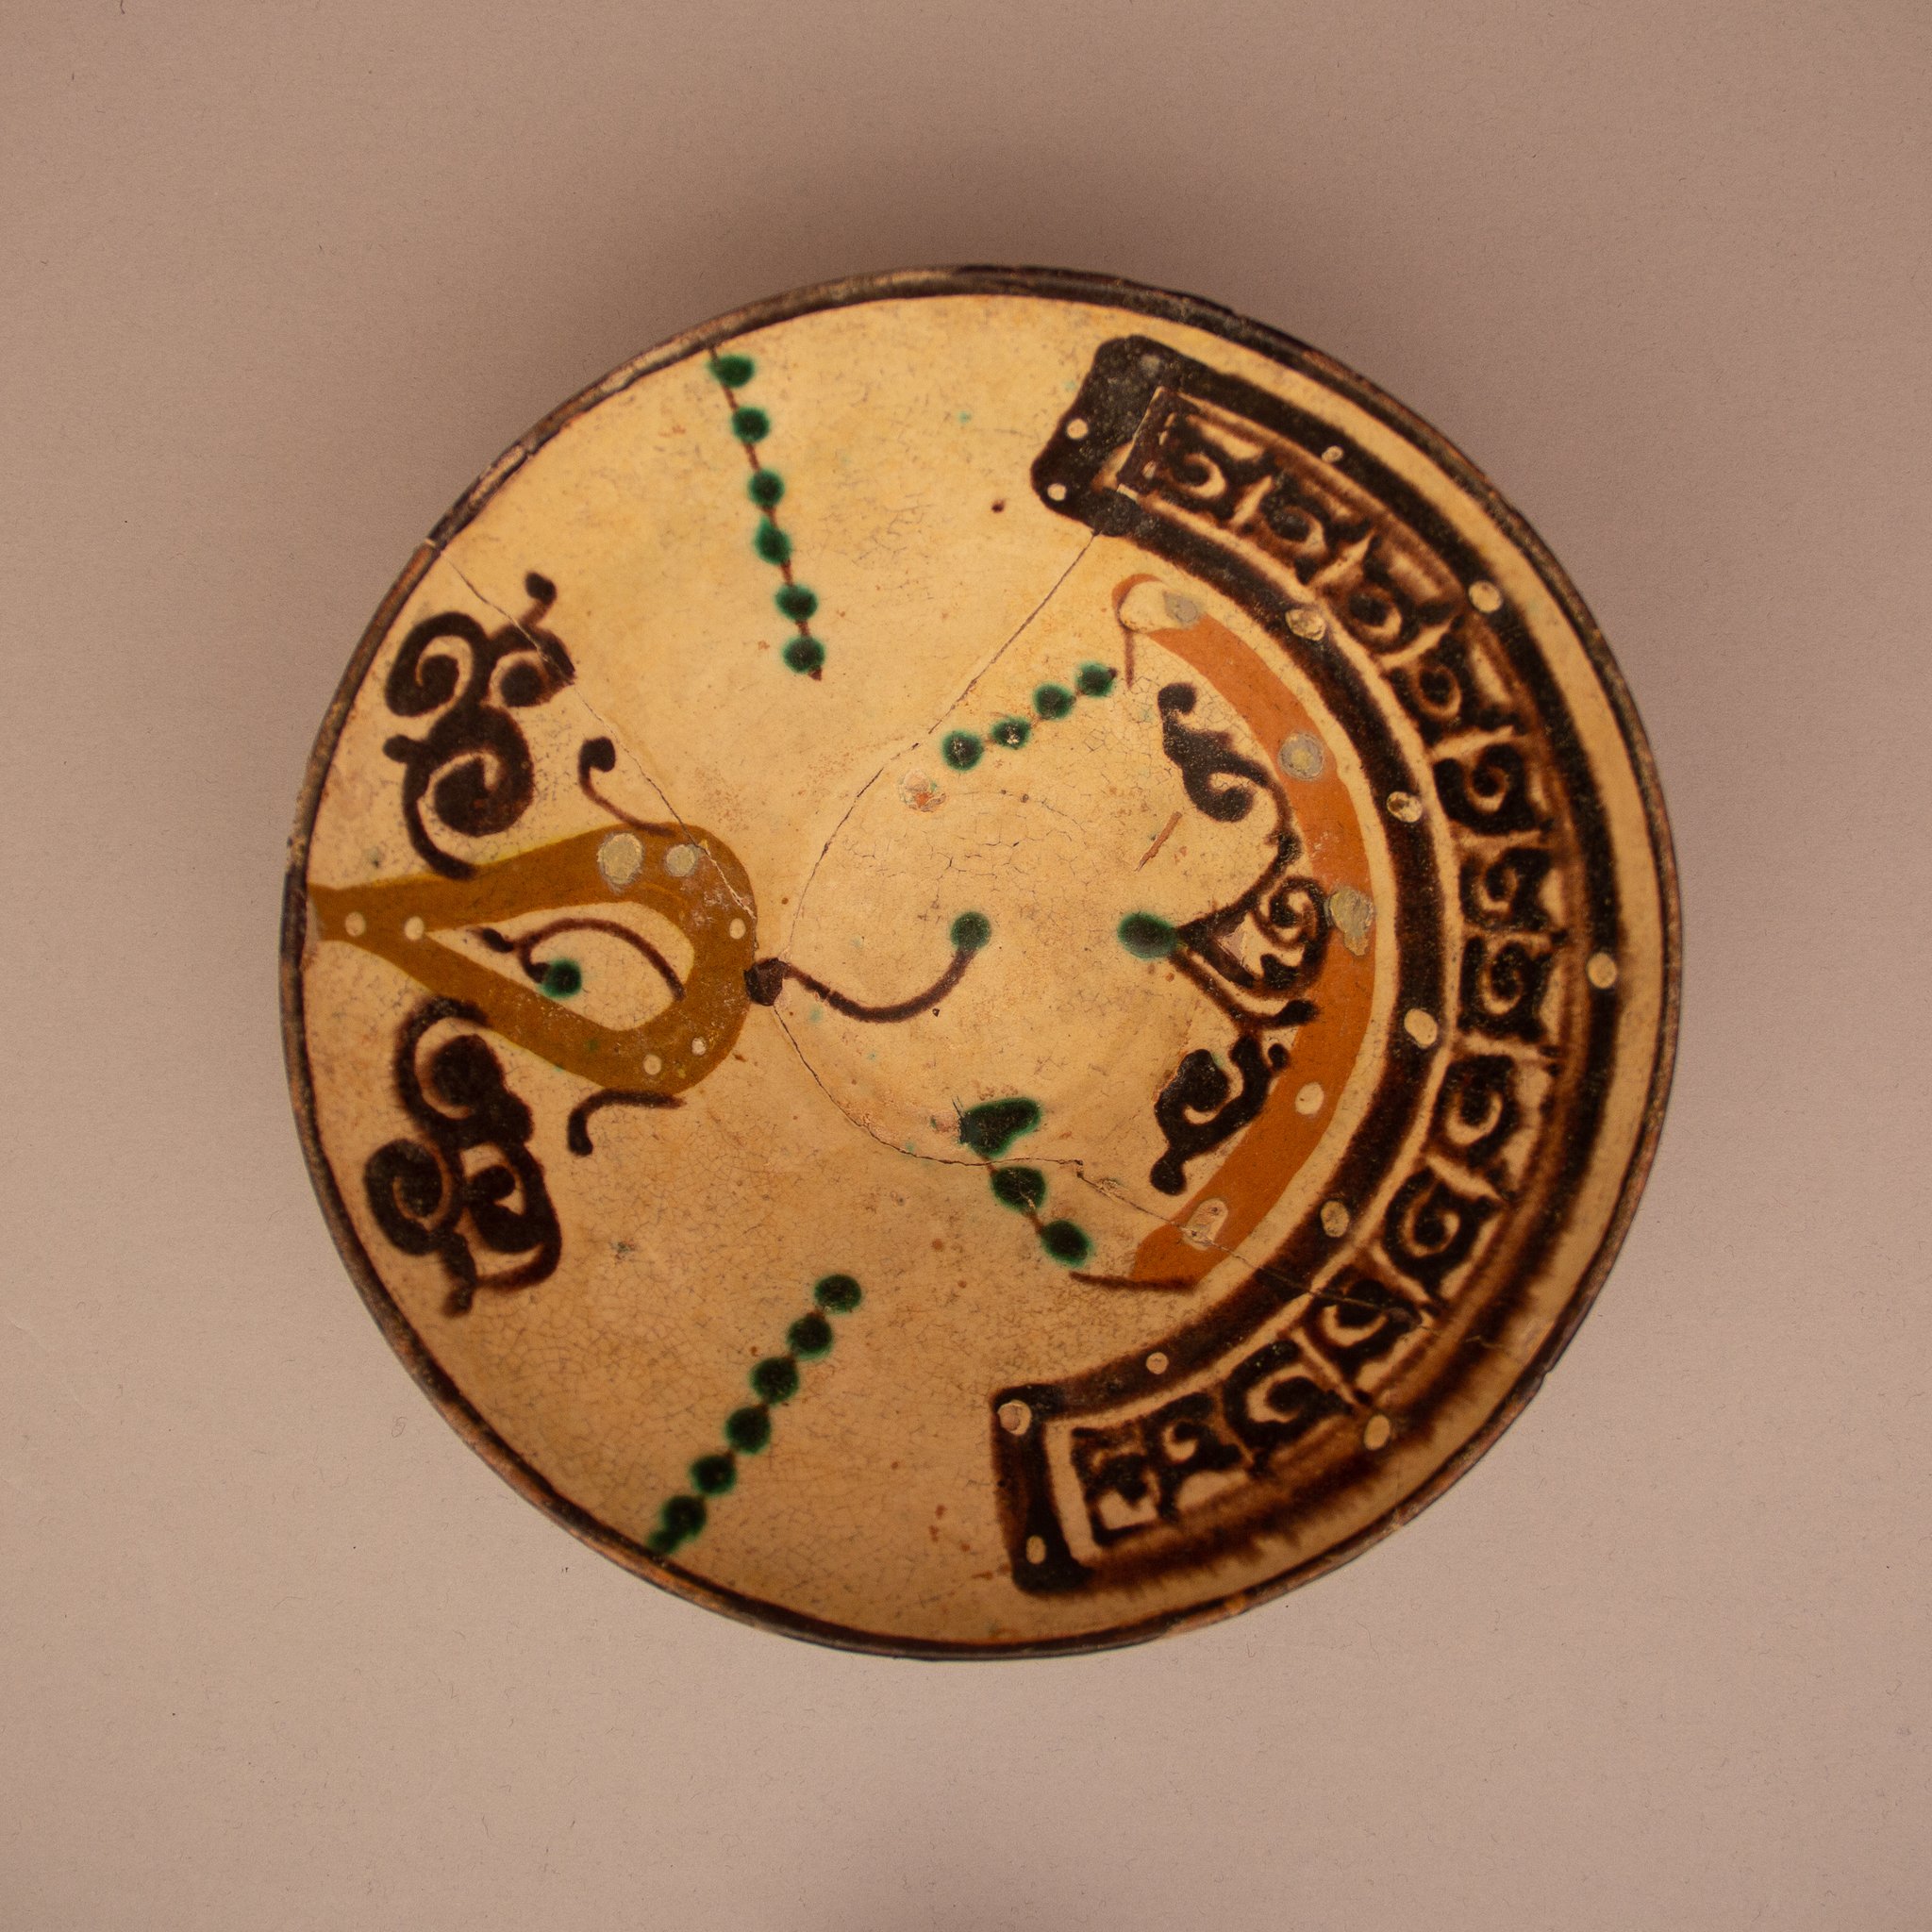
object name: bowl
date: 901-1000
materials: earthenware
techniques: glazing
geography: iran